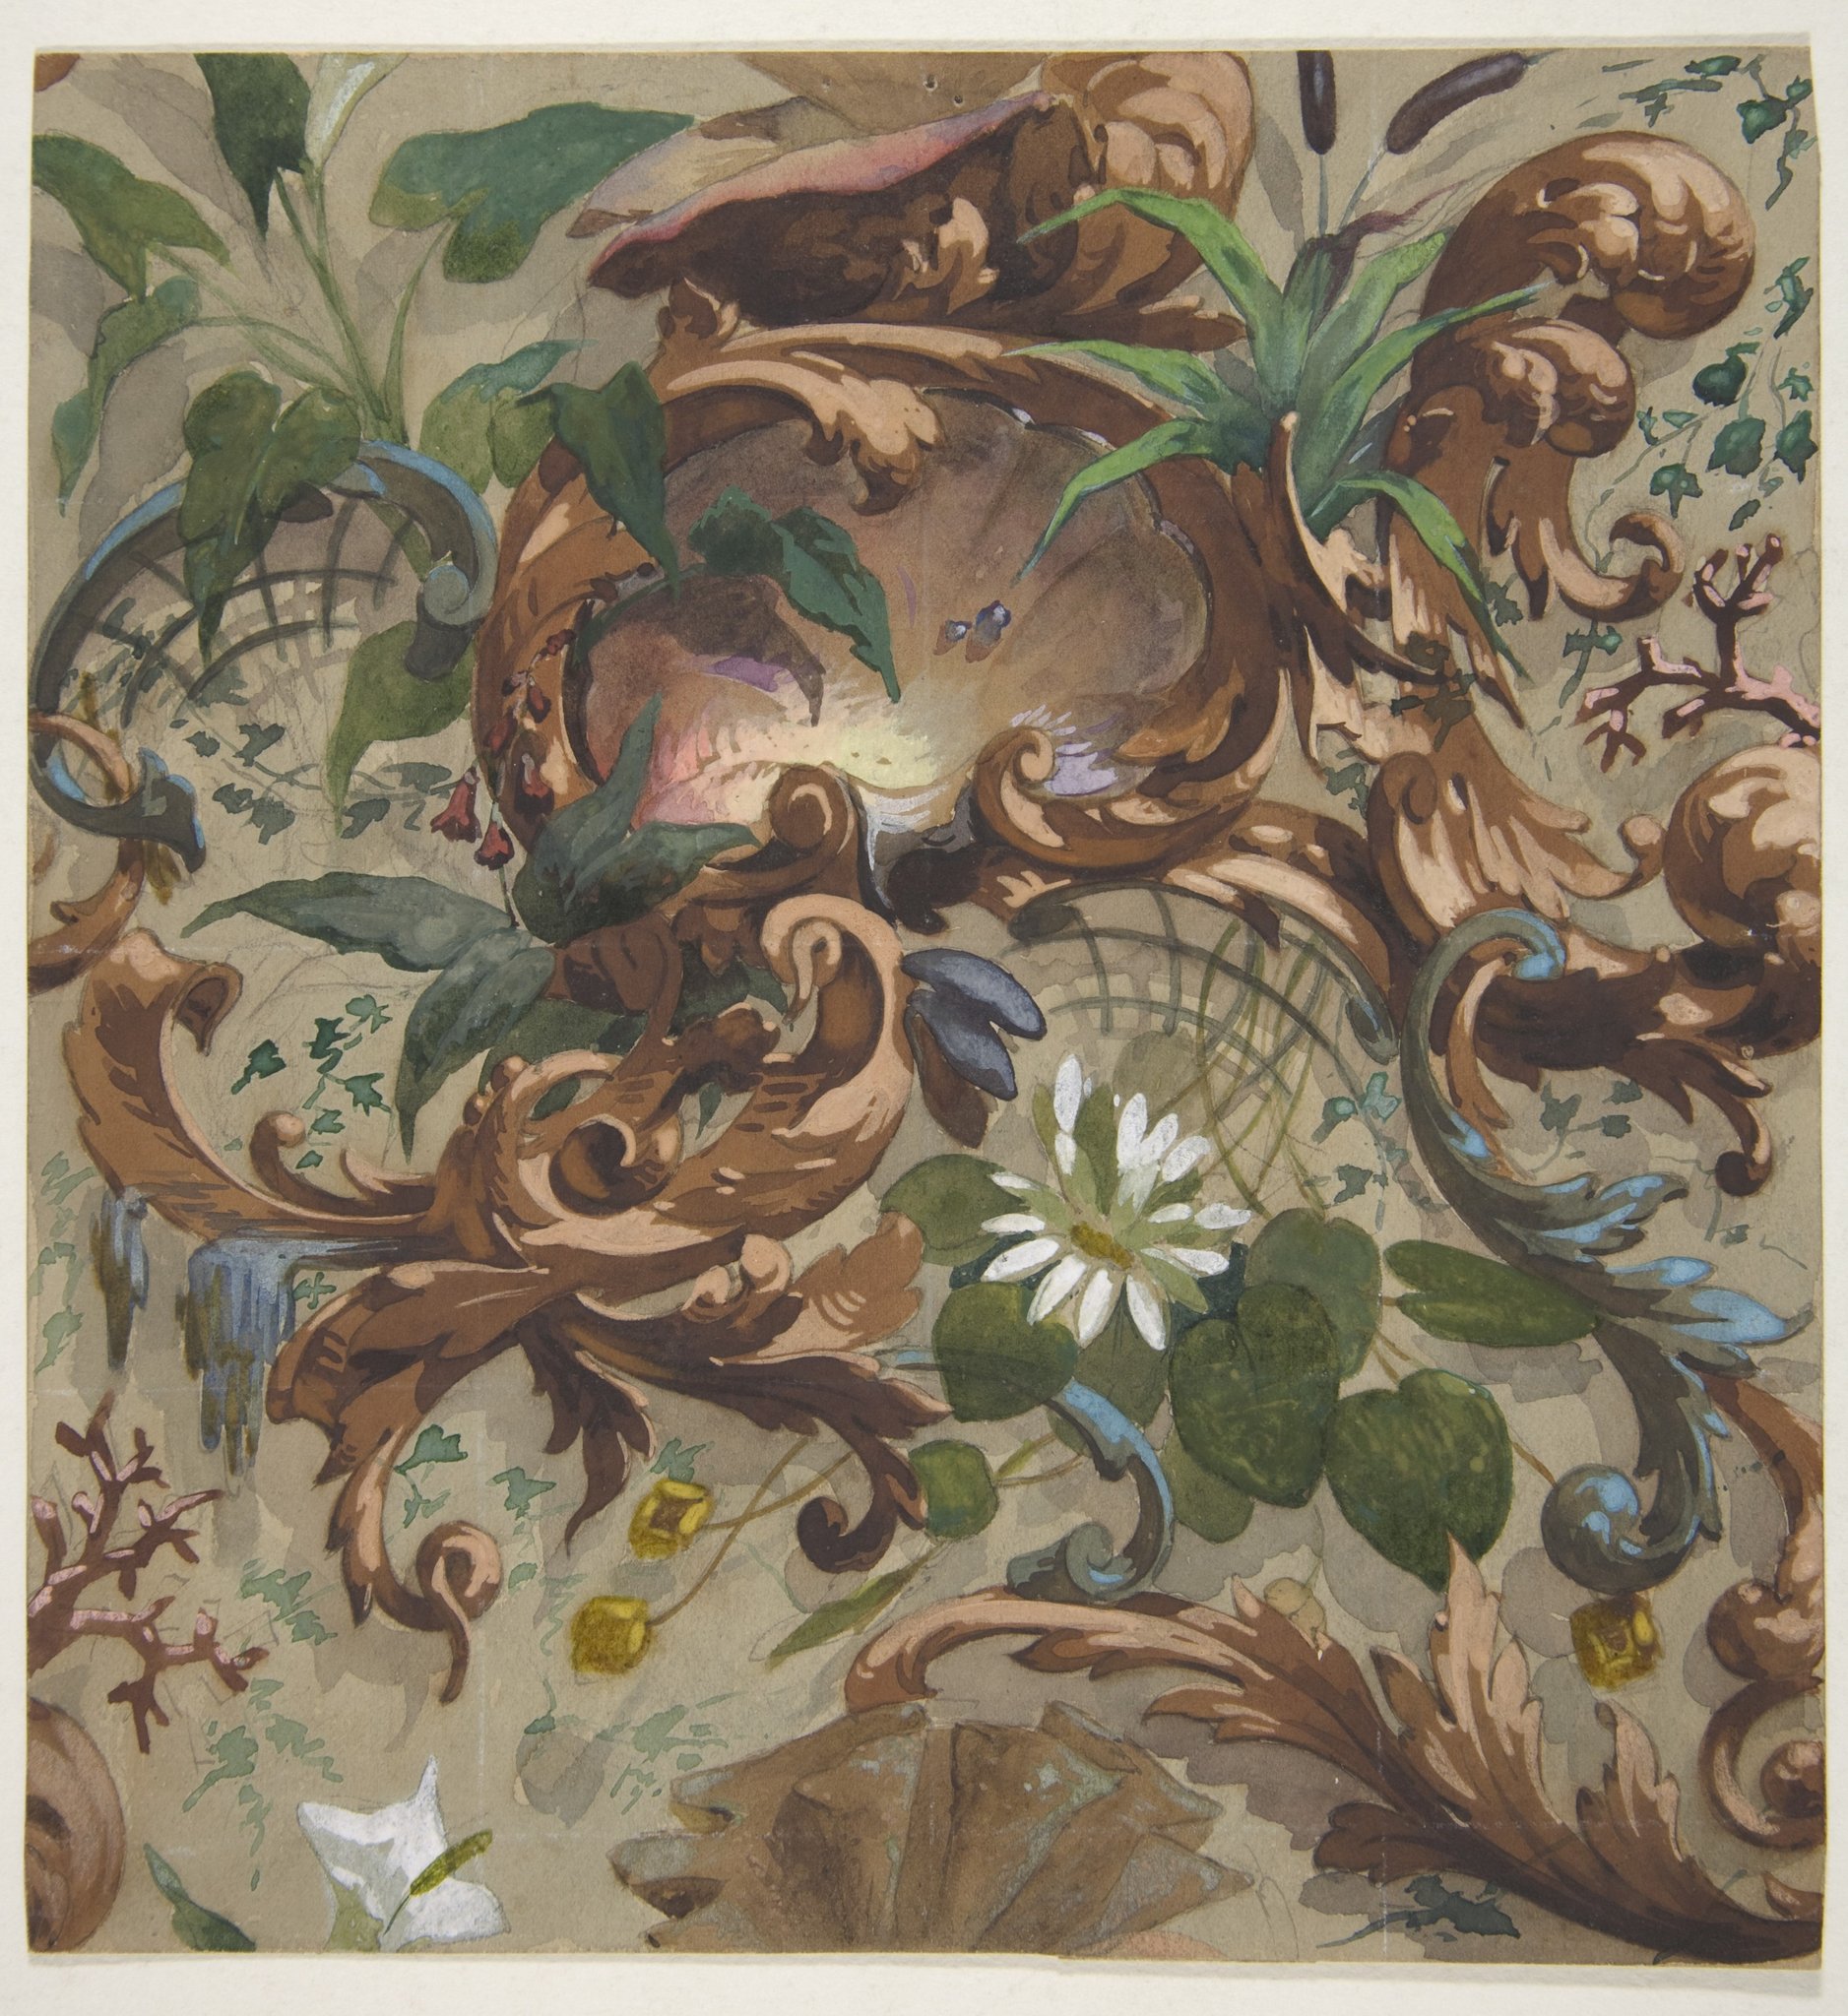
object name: drawing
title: Design for wallpaper featuring shells, waterlilies, and cattails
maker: jules-edmond-charles lachaise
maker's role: artist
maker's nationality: french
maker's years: 1897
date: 1830-1897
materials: gouache, paper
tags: flowers,leaves,shells